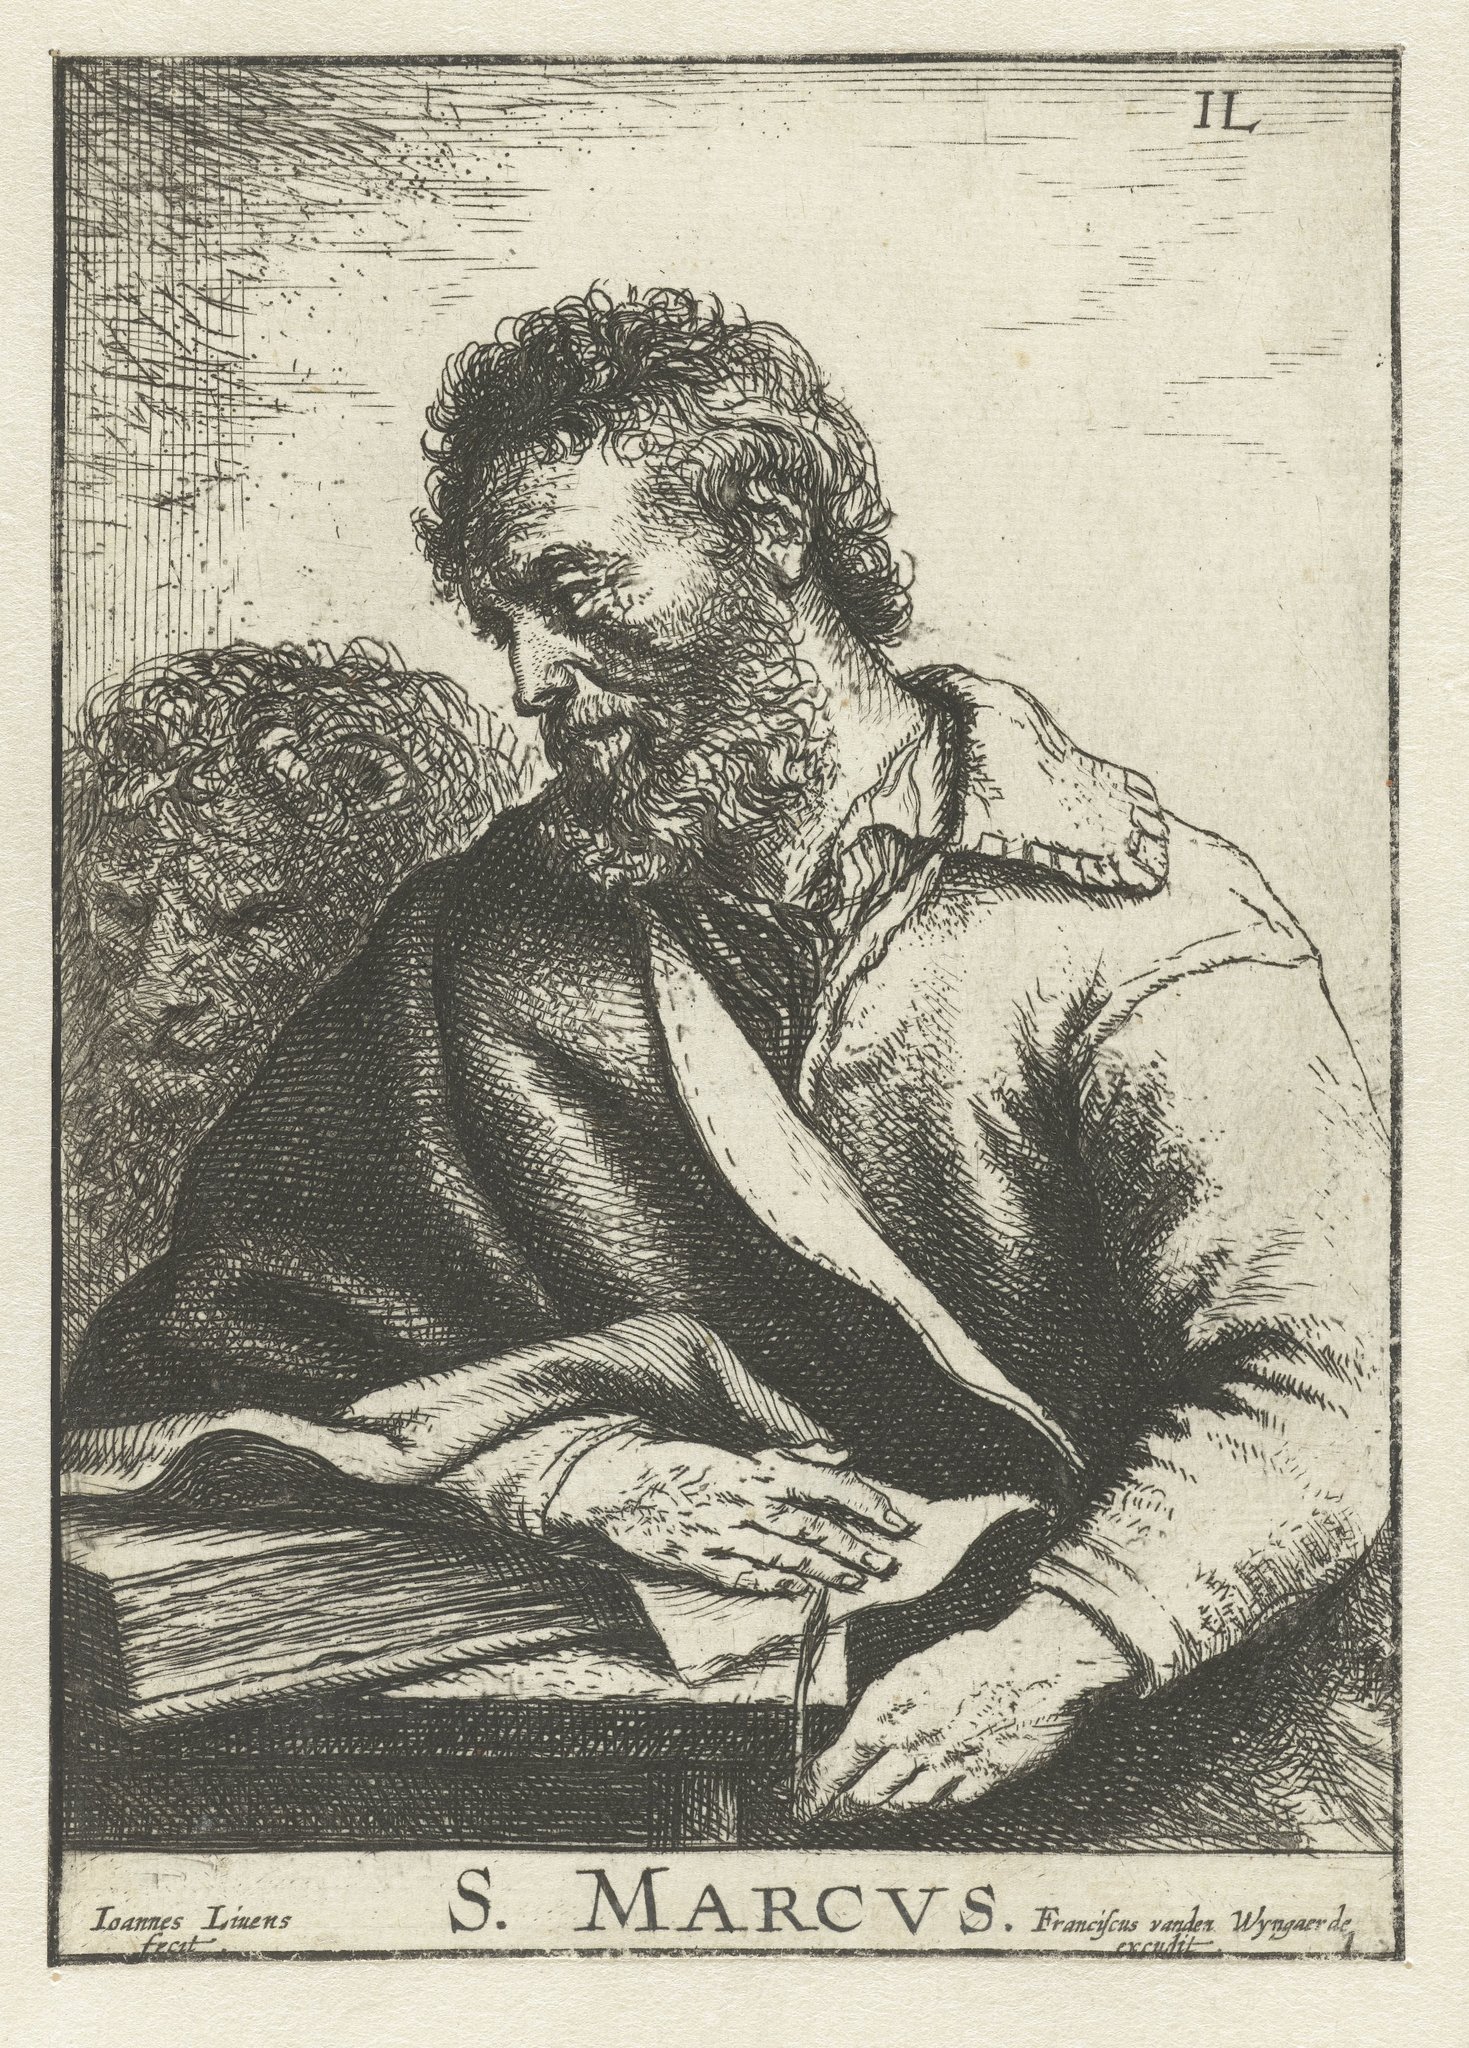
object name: print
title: Heilige Marcus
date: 1625-1674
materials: paper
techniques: engraving, etching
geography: antwerp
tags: lion (possibly with book) ~ symbol of st. mark, mark (marcus) the evangelist, and bishop of alexandria; possible attributes: book, (winged) lion, pen and inkhorn, scroll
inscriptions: collector's mark: Lugt 2228a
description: De evangelist Markus met zijn attribuut de leeuw